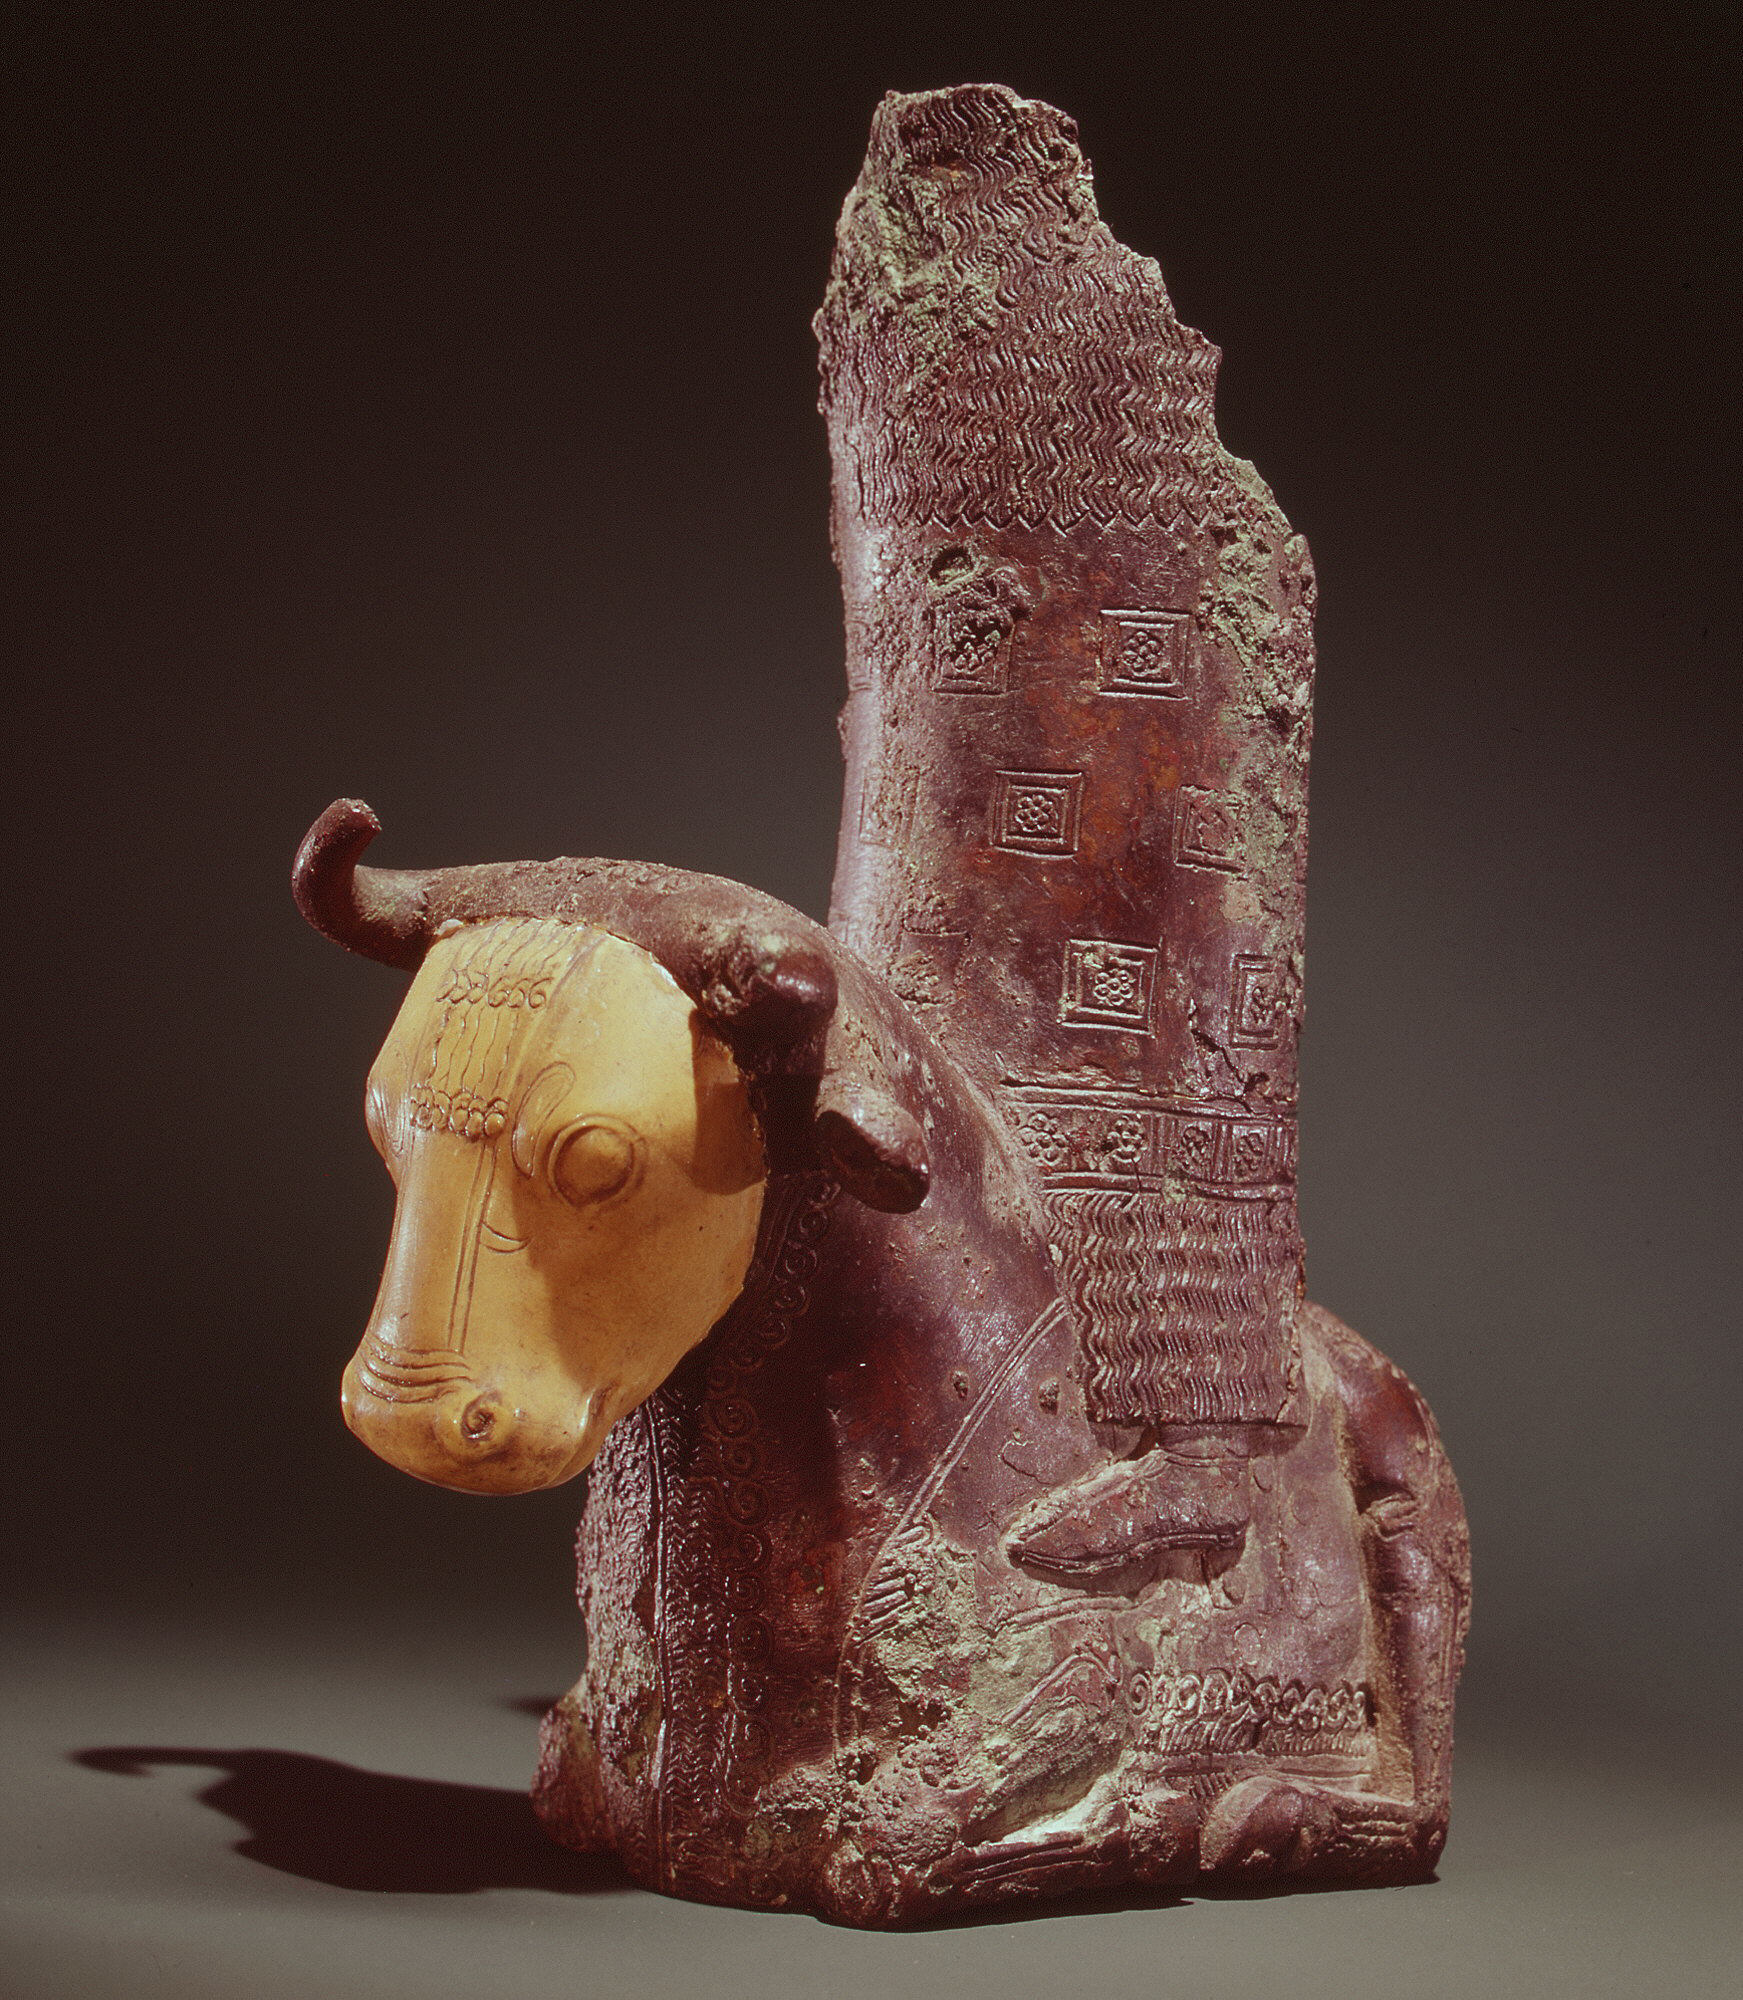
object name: sculpture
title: Part of a throne with deity on a bull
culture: urartian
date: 734-601 BCE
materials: bronze, plastic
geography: urartu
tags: bulls